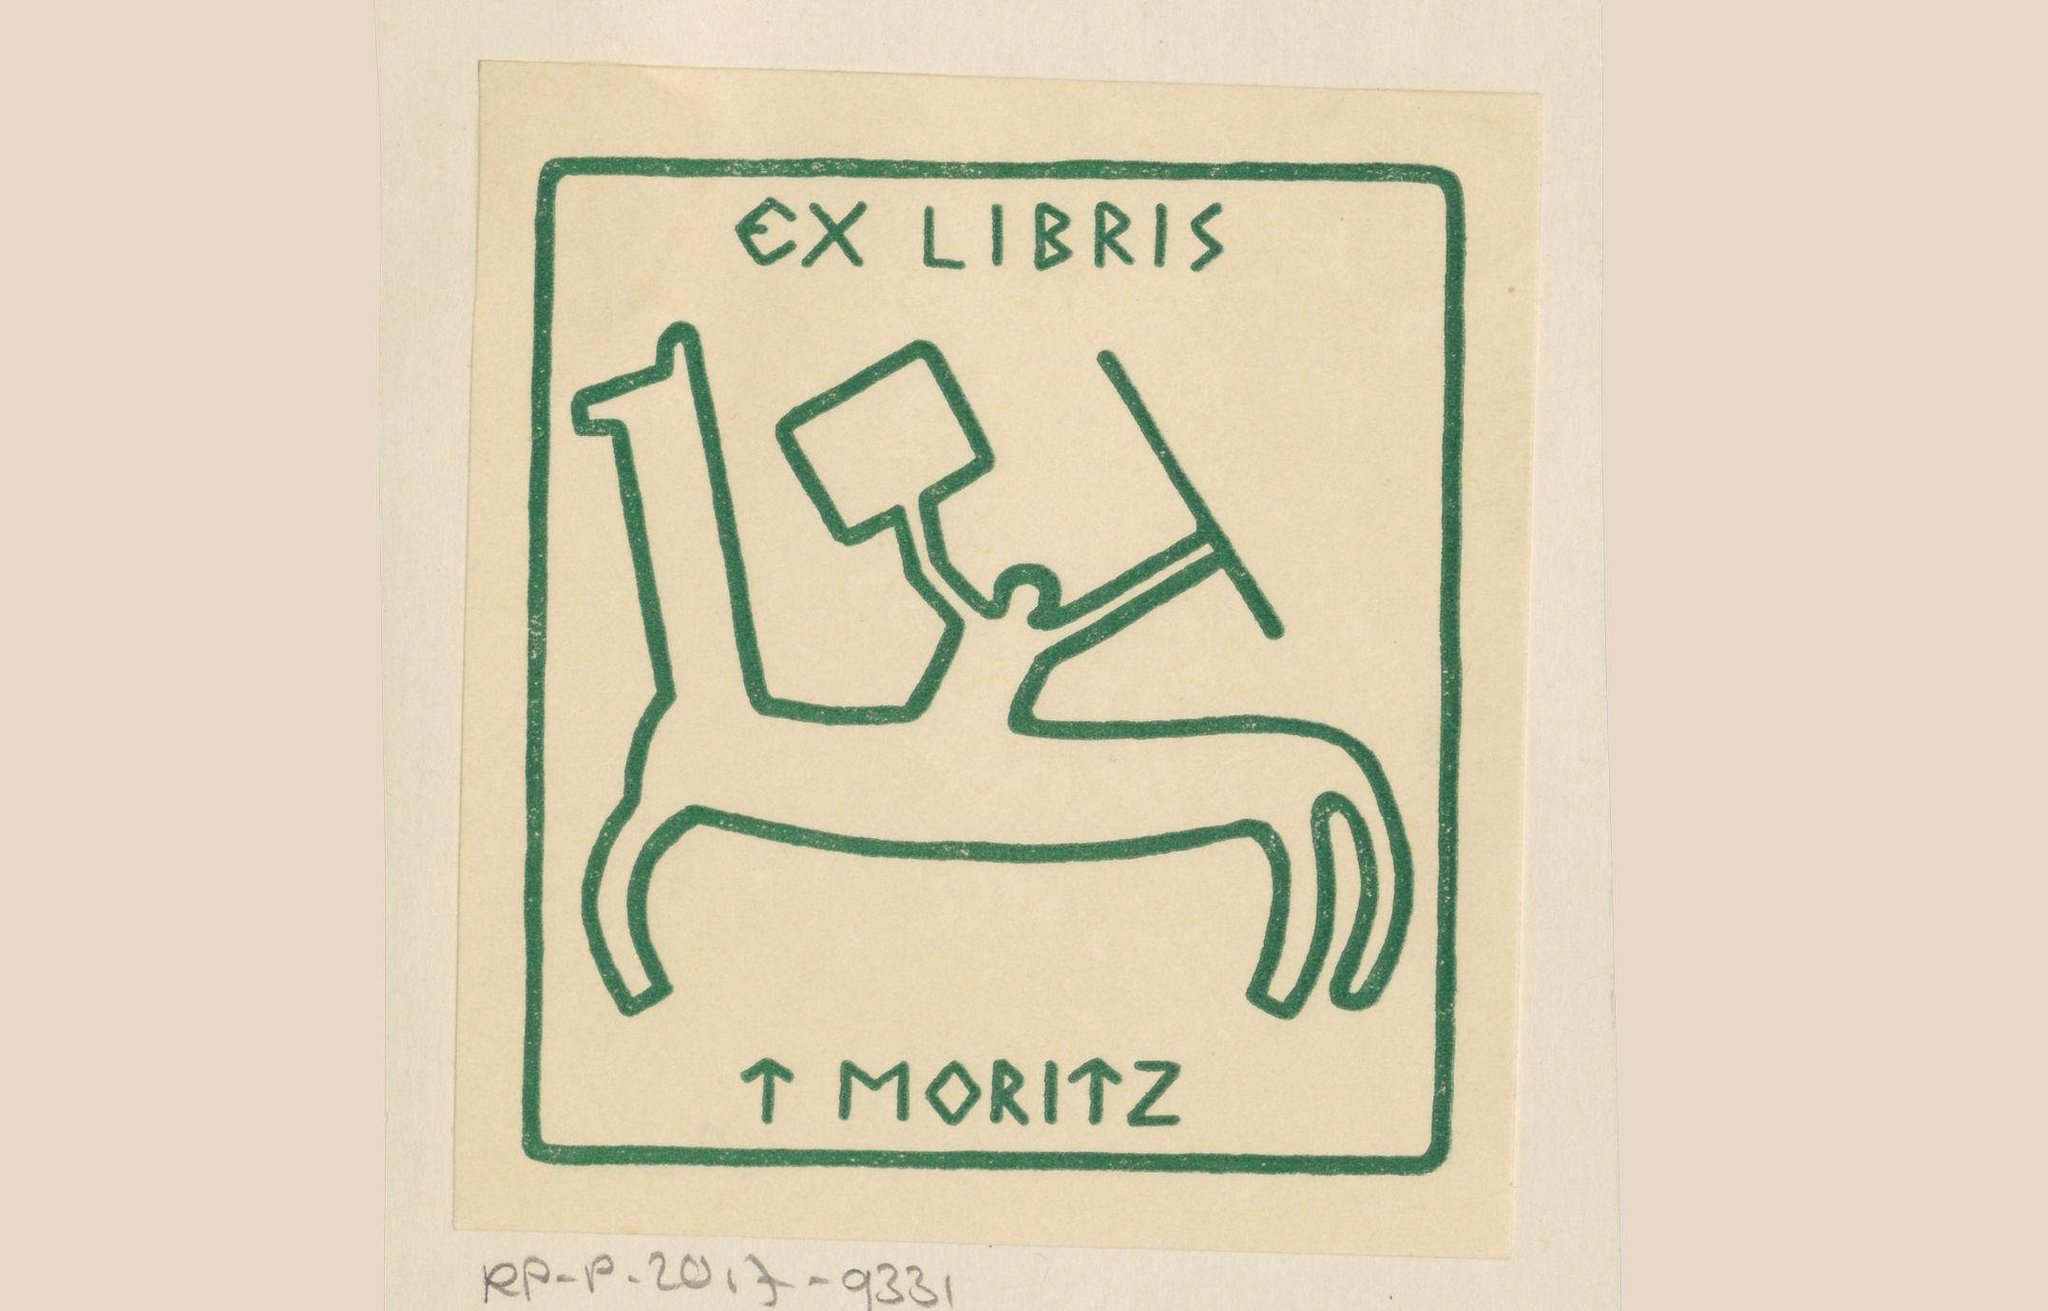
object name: bookplate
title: Ex libris van Torsten Moritz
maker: Anonymous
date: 1941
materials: paper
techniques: printing block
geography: sweden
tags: print maker, torsten moritz, riding a horse, ass, or mule; rider, horseman, protective weapons: shield, horse